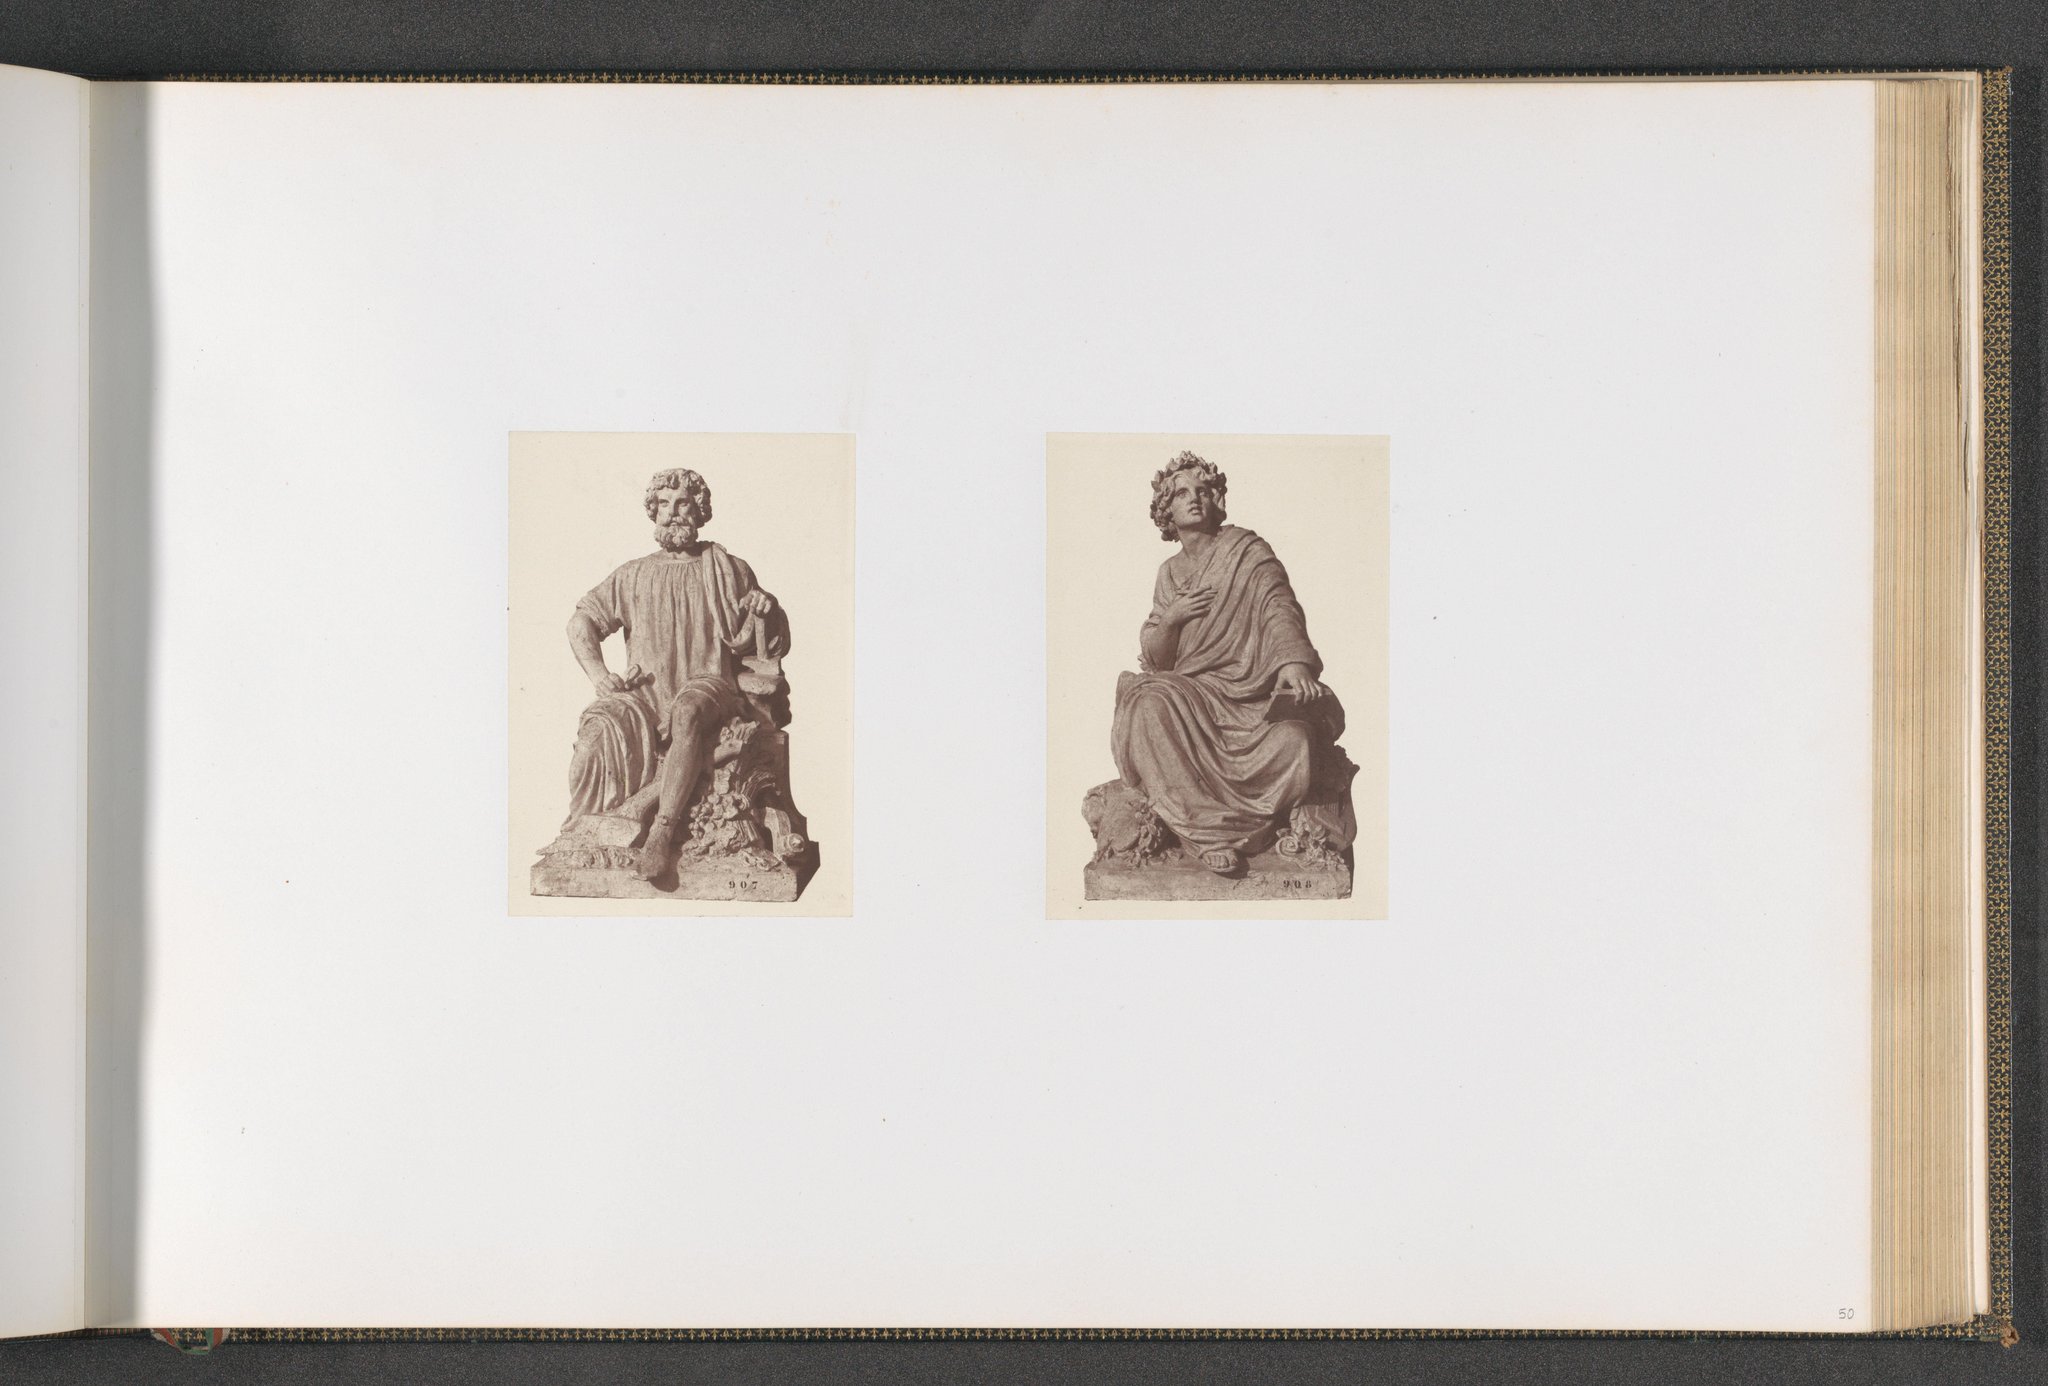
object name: photograph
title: Gipsmodellen voor beeldhouwwerken op het Palais du Louvre: links "Le Travail manuel" en rechts "L'Art" door Auguste Ottin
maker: édouard denis baldus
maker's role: fotograaf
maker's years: 1813-1889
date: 1855-1857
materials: paper, photographic support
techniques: salted paper print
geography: paris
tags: piece of sculpture, reproduction of a piece of sculpture, permanent exhibition, museum, paris, tuileries palace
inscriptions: number: ‘907 en 908’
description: Onderdeel van Réunion des Tuileries au Louvre 1852-1857, album 2.